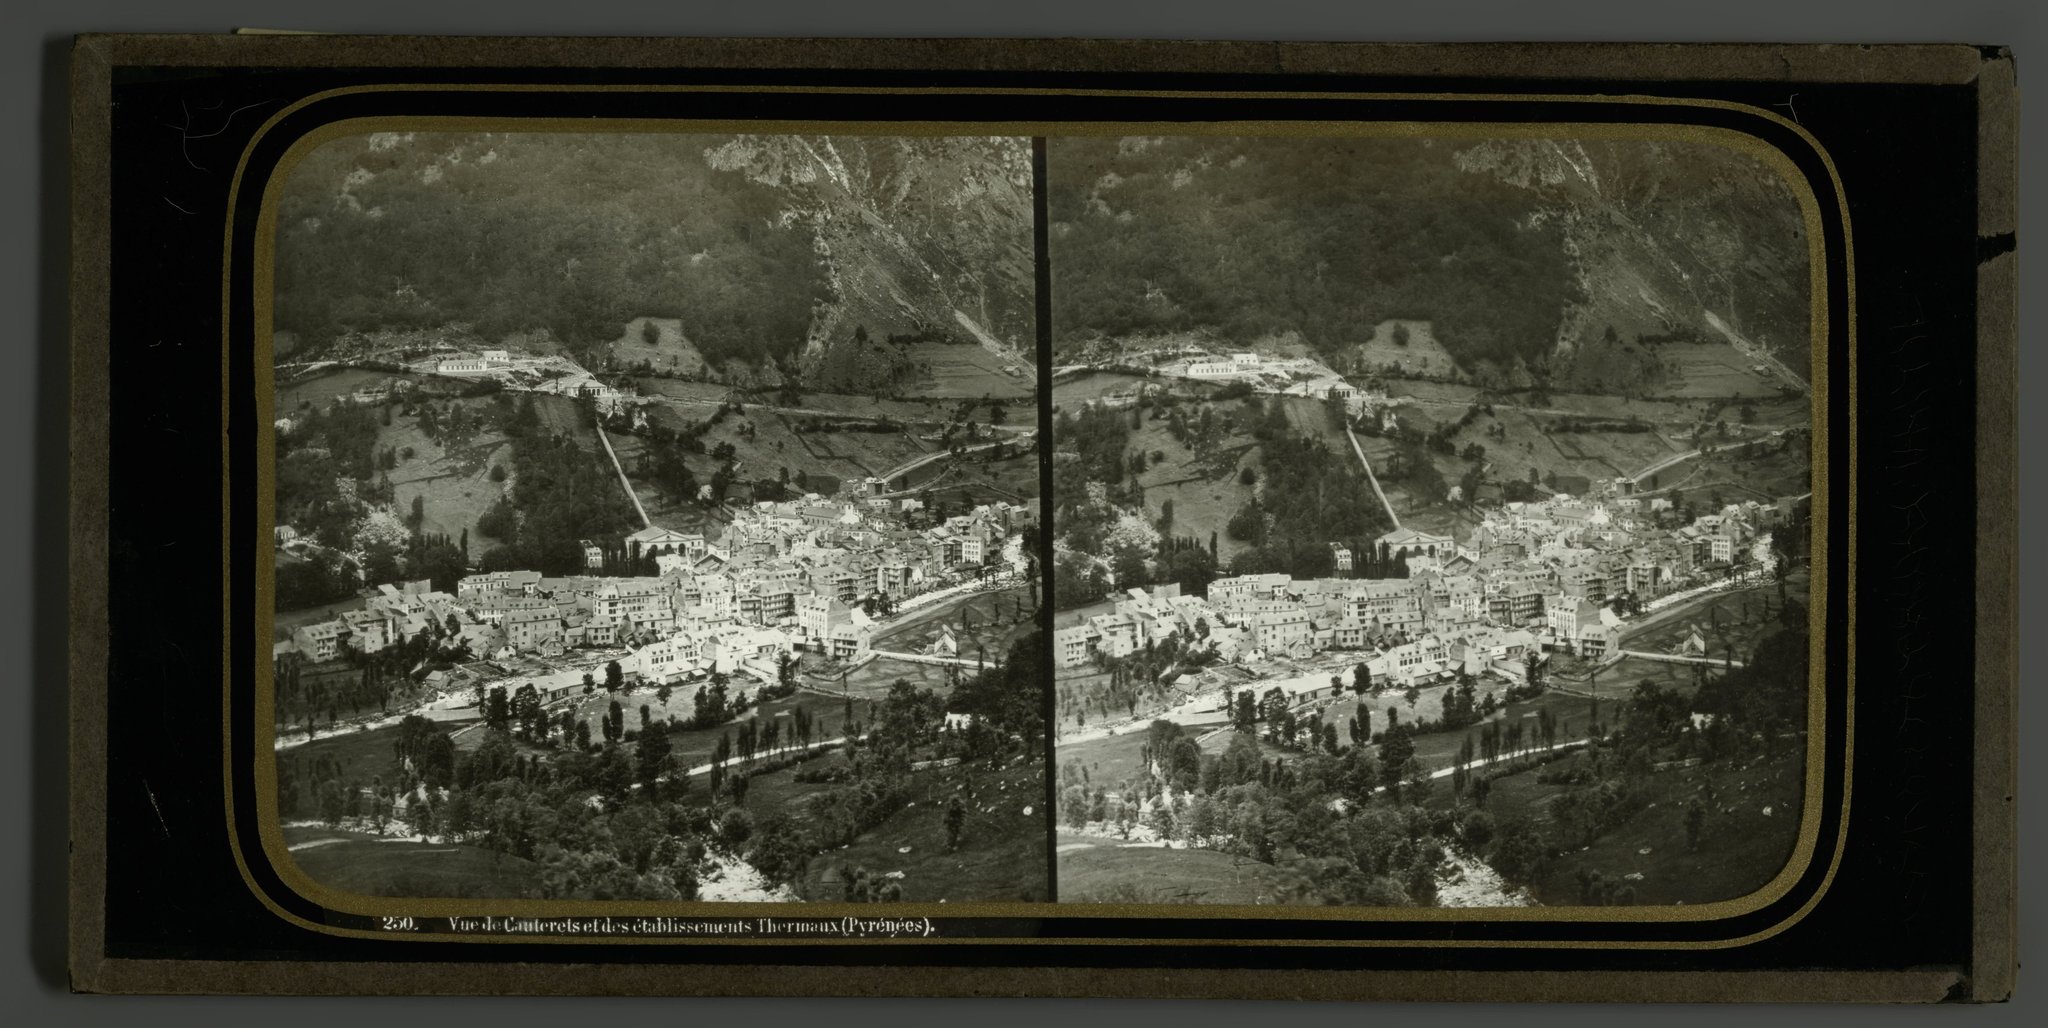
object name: stereoscopic photograph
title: Gezicht op de thermen van Cauterets, Frankrijk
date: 1860-1870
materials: glass, paper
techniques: slide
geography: cauterets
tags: public baths, prospect of city, town panorama, silhouette of city, mountains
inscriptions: number: ‘250’, retailer's mark: ‘[.]. WAKKER/ Kalverstraat/ bij de Heiligeweg D 135./ 4’